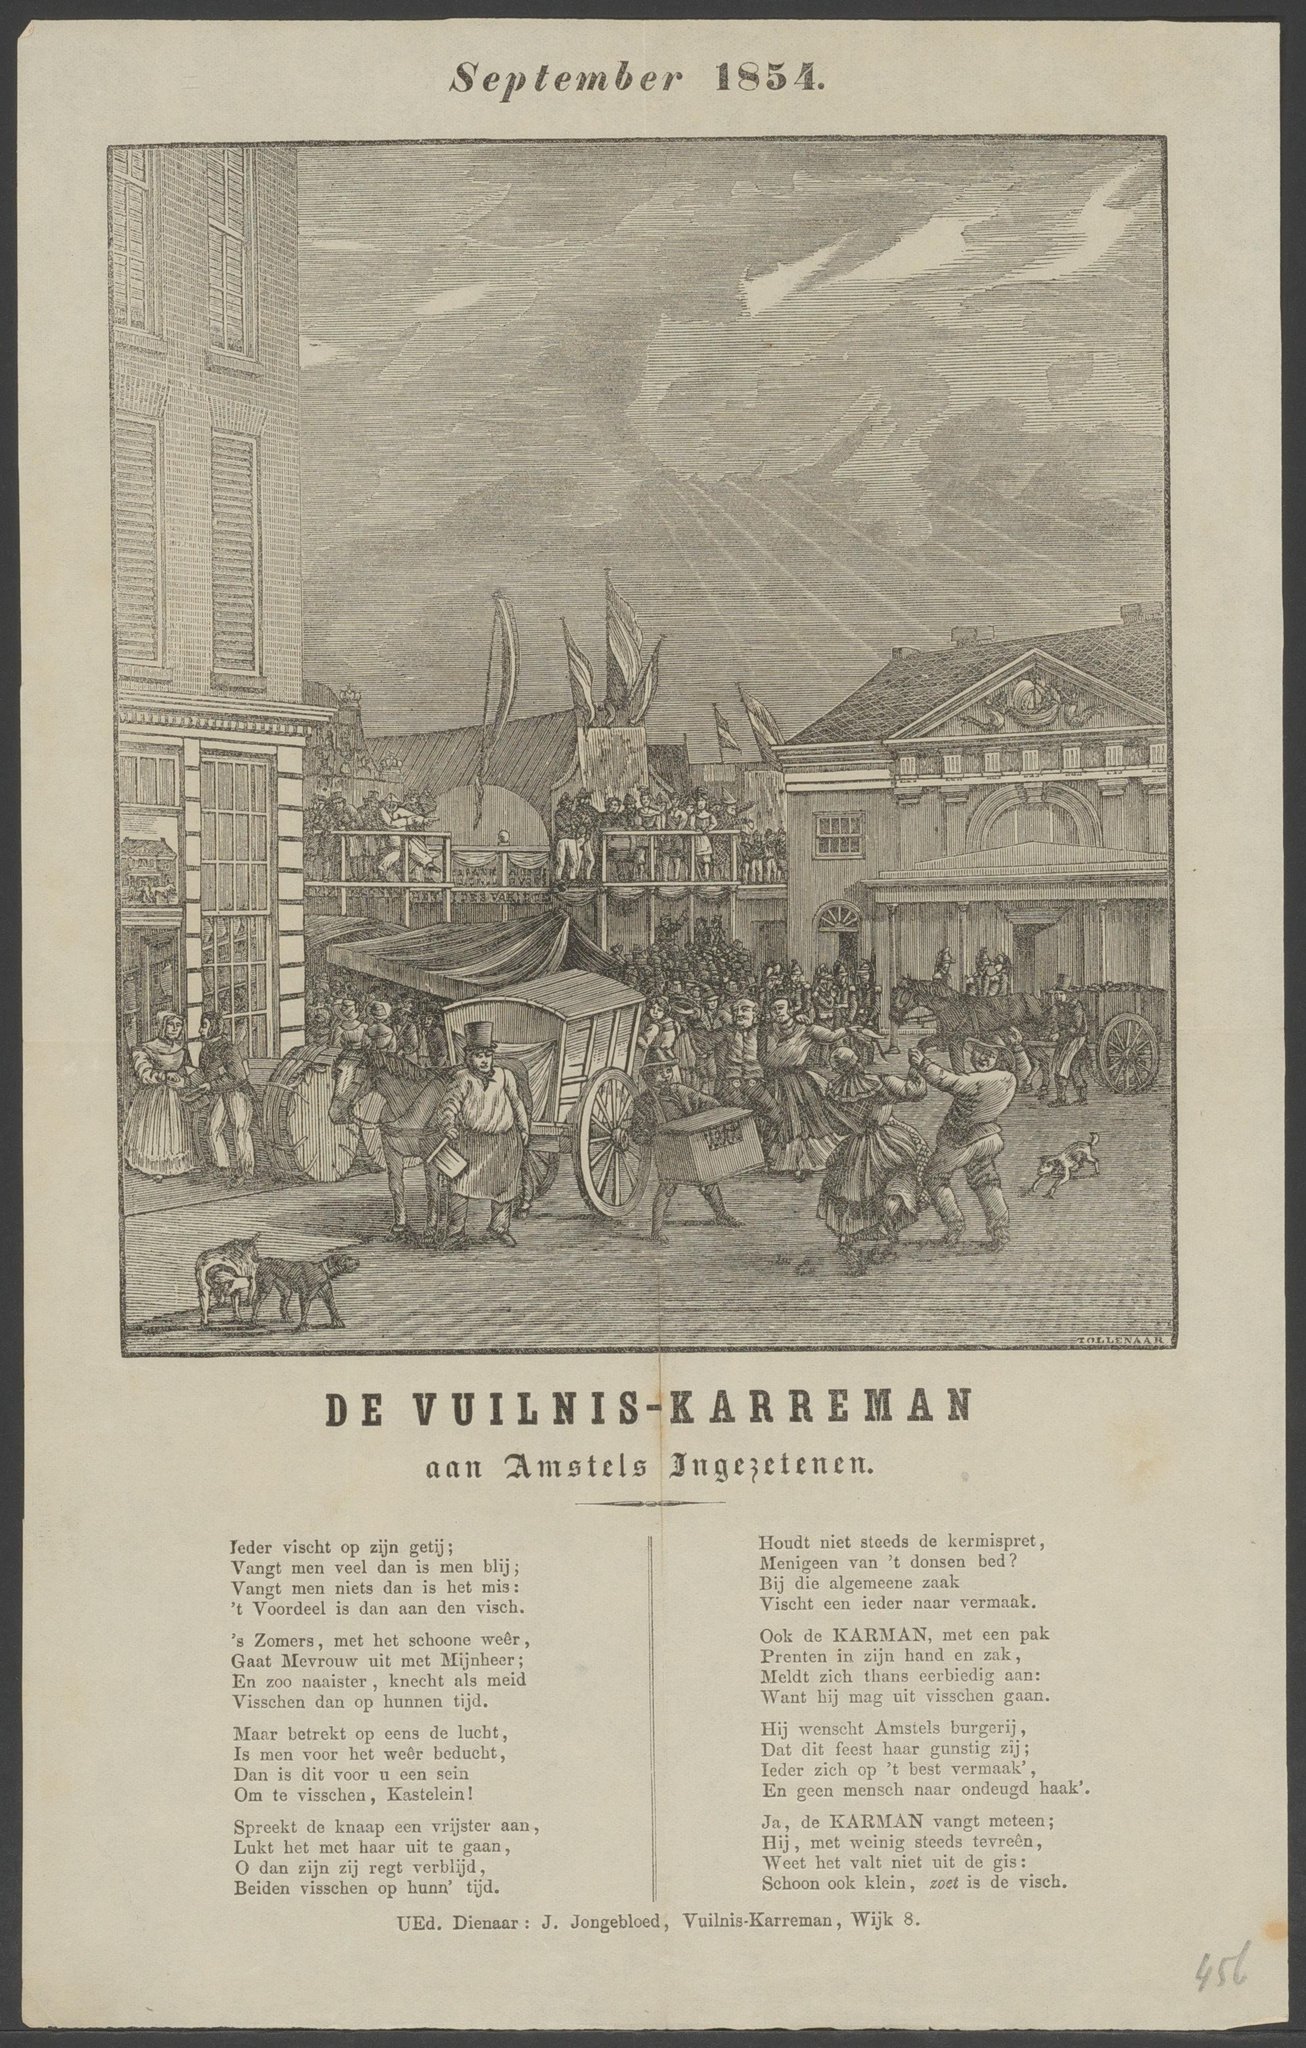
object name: fair print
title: Kermisprent van de vuilnismannen van Amsterdam voor het jaar 1854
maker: dirk wijbrand tollenaar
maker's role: print maker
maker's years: 1808-1858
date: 1854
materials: paper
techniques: letterpress printing, engraving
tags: street, garbage collection, amsterdam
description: Kermisprent van de Amsterdamse vuilnismannen voor het jaar 1854. Gezicht op de kermis op de Botermarkt met de oude Waag. Op de markt twee vuilniskarren. Met gedicht in twee kolommen. Van de vuilniskarman in de wijk no. 8: J. Jongebloed. Onderwerpsrubrieken binnen de Atlas Zeden en Gewoonten: Zeden en gewoonten in engeren zin, Volksleven, Volksbladen, Nieuwjaars- en Kerstwenschen, Amsterdam.